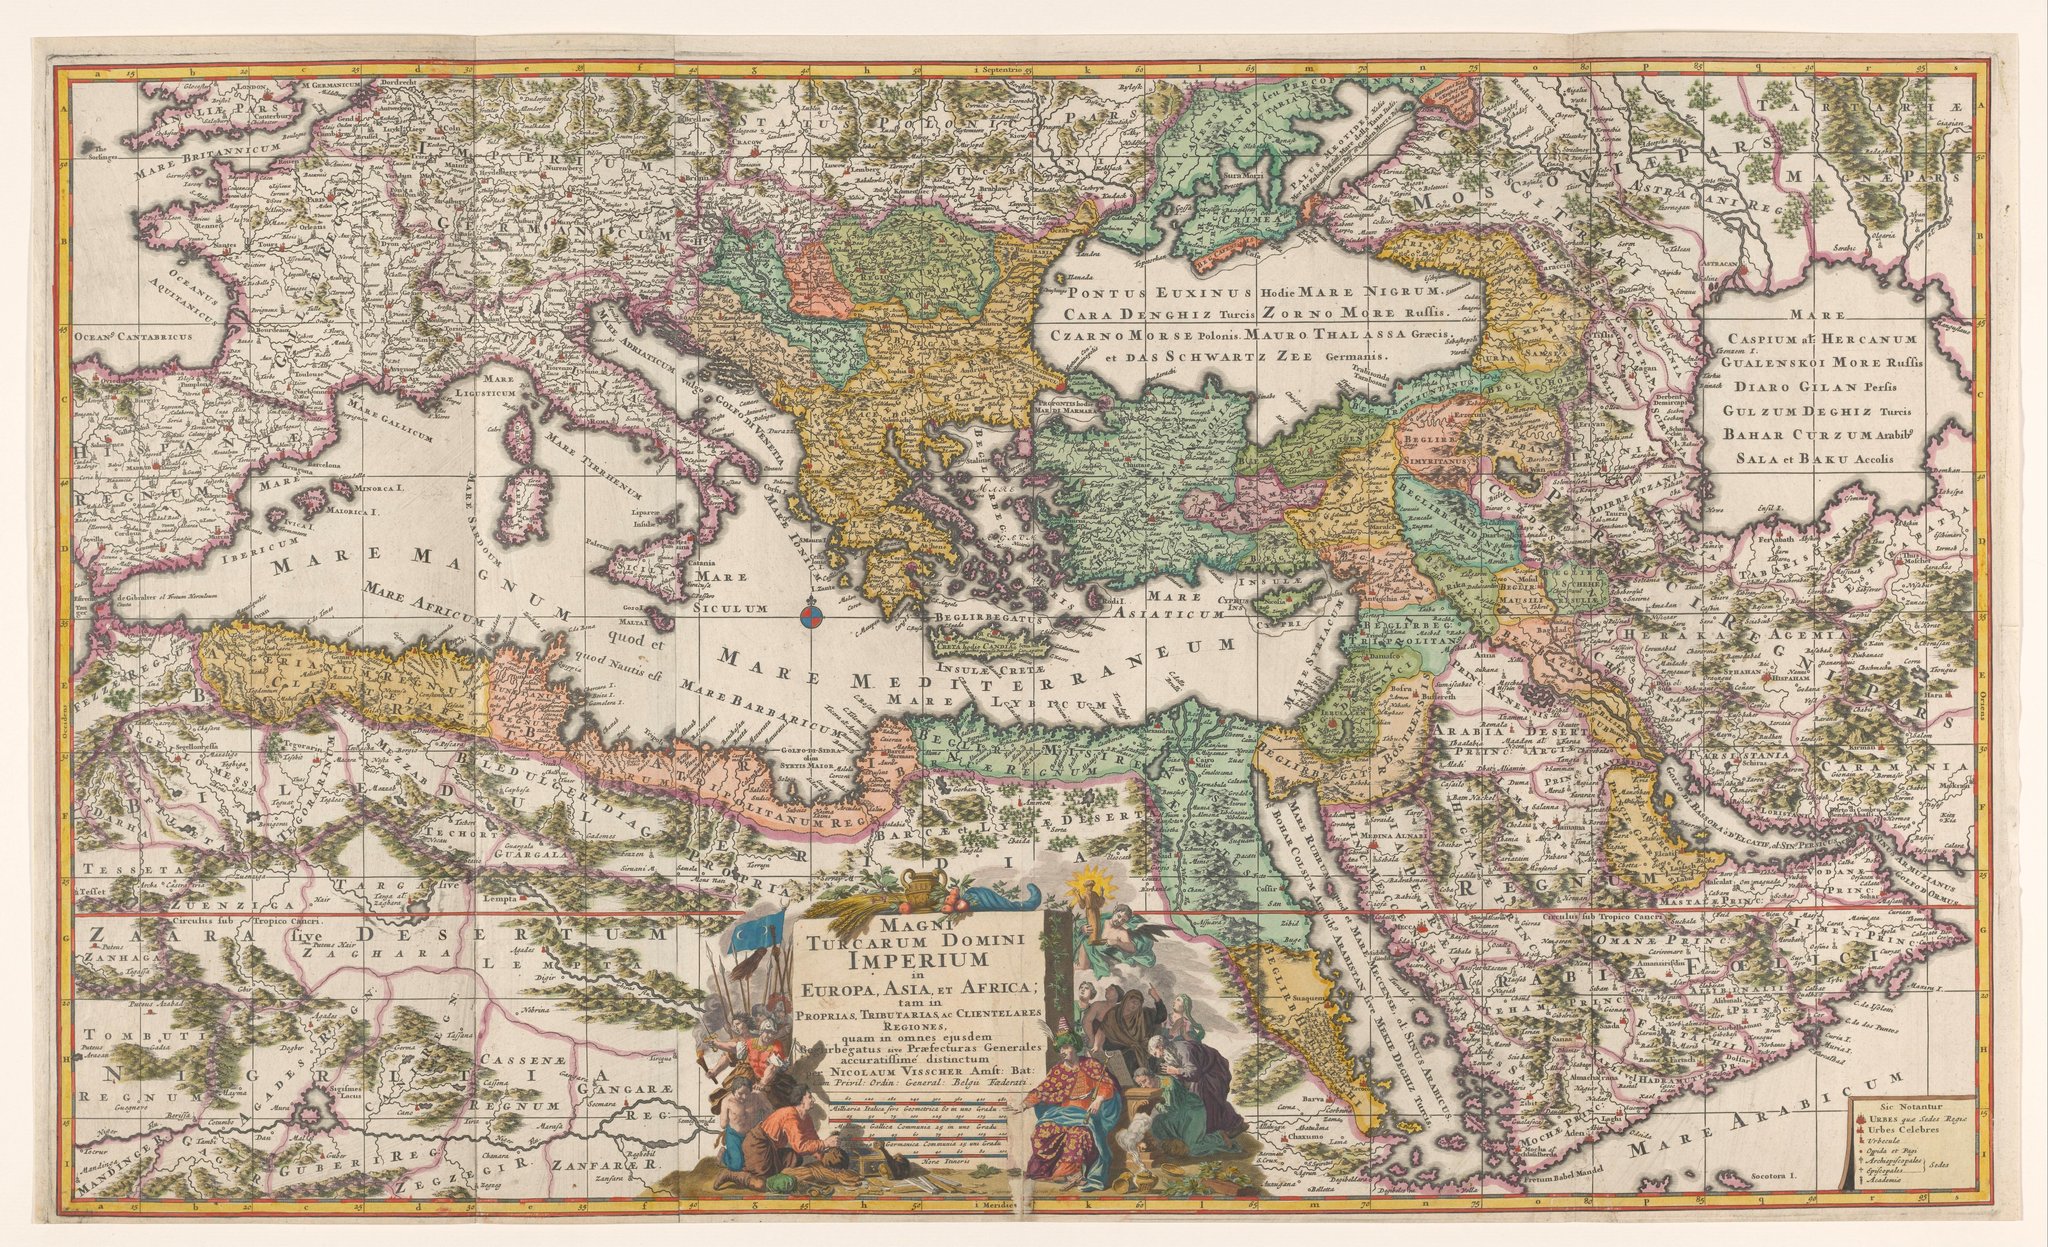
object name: map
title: Kaart van het Ottomaanse Rijk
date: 1650-1700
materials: paper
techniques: colour, engraving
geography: amsterdam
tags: maps of separate countries or regions, europe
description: Kaart van het Middellandse zeegebied met delen van Europa, Afrika en Azië met daarop aangegeven de grenzen van het Ottomaanse Rijk rond 1680. Links van het titelcartouche soldaten die een krijgsgevangene met zich meevoeren. Een geknielde man biedt de sultan geschenken aan. Rechts een scène waarin de bekering tot de Islam wordt voorgesteld. Twee mannen knielen voor een opengeslagen boek, waarschijnlijk de Bijbel. De figuur die het boek vasthoudt wijst hen op een beeld van Mohammed dat door een duivel wordt vastgehouden.